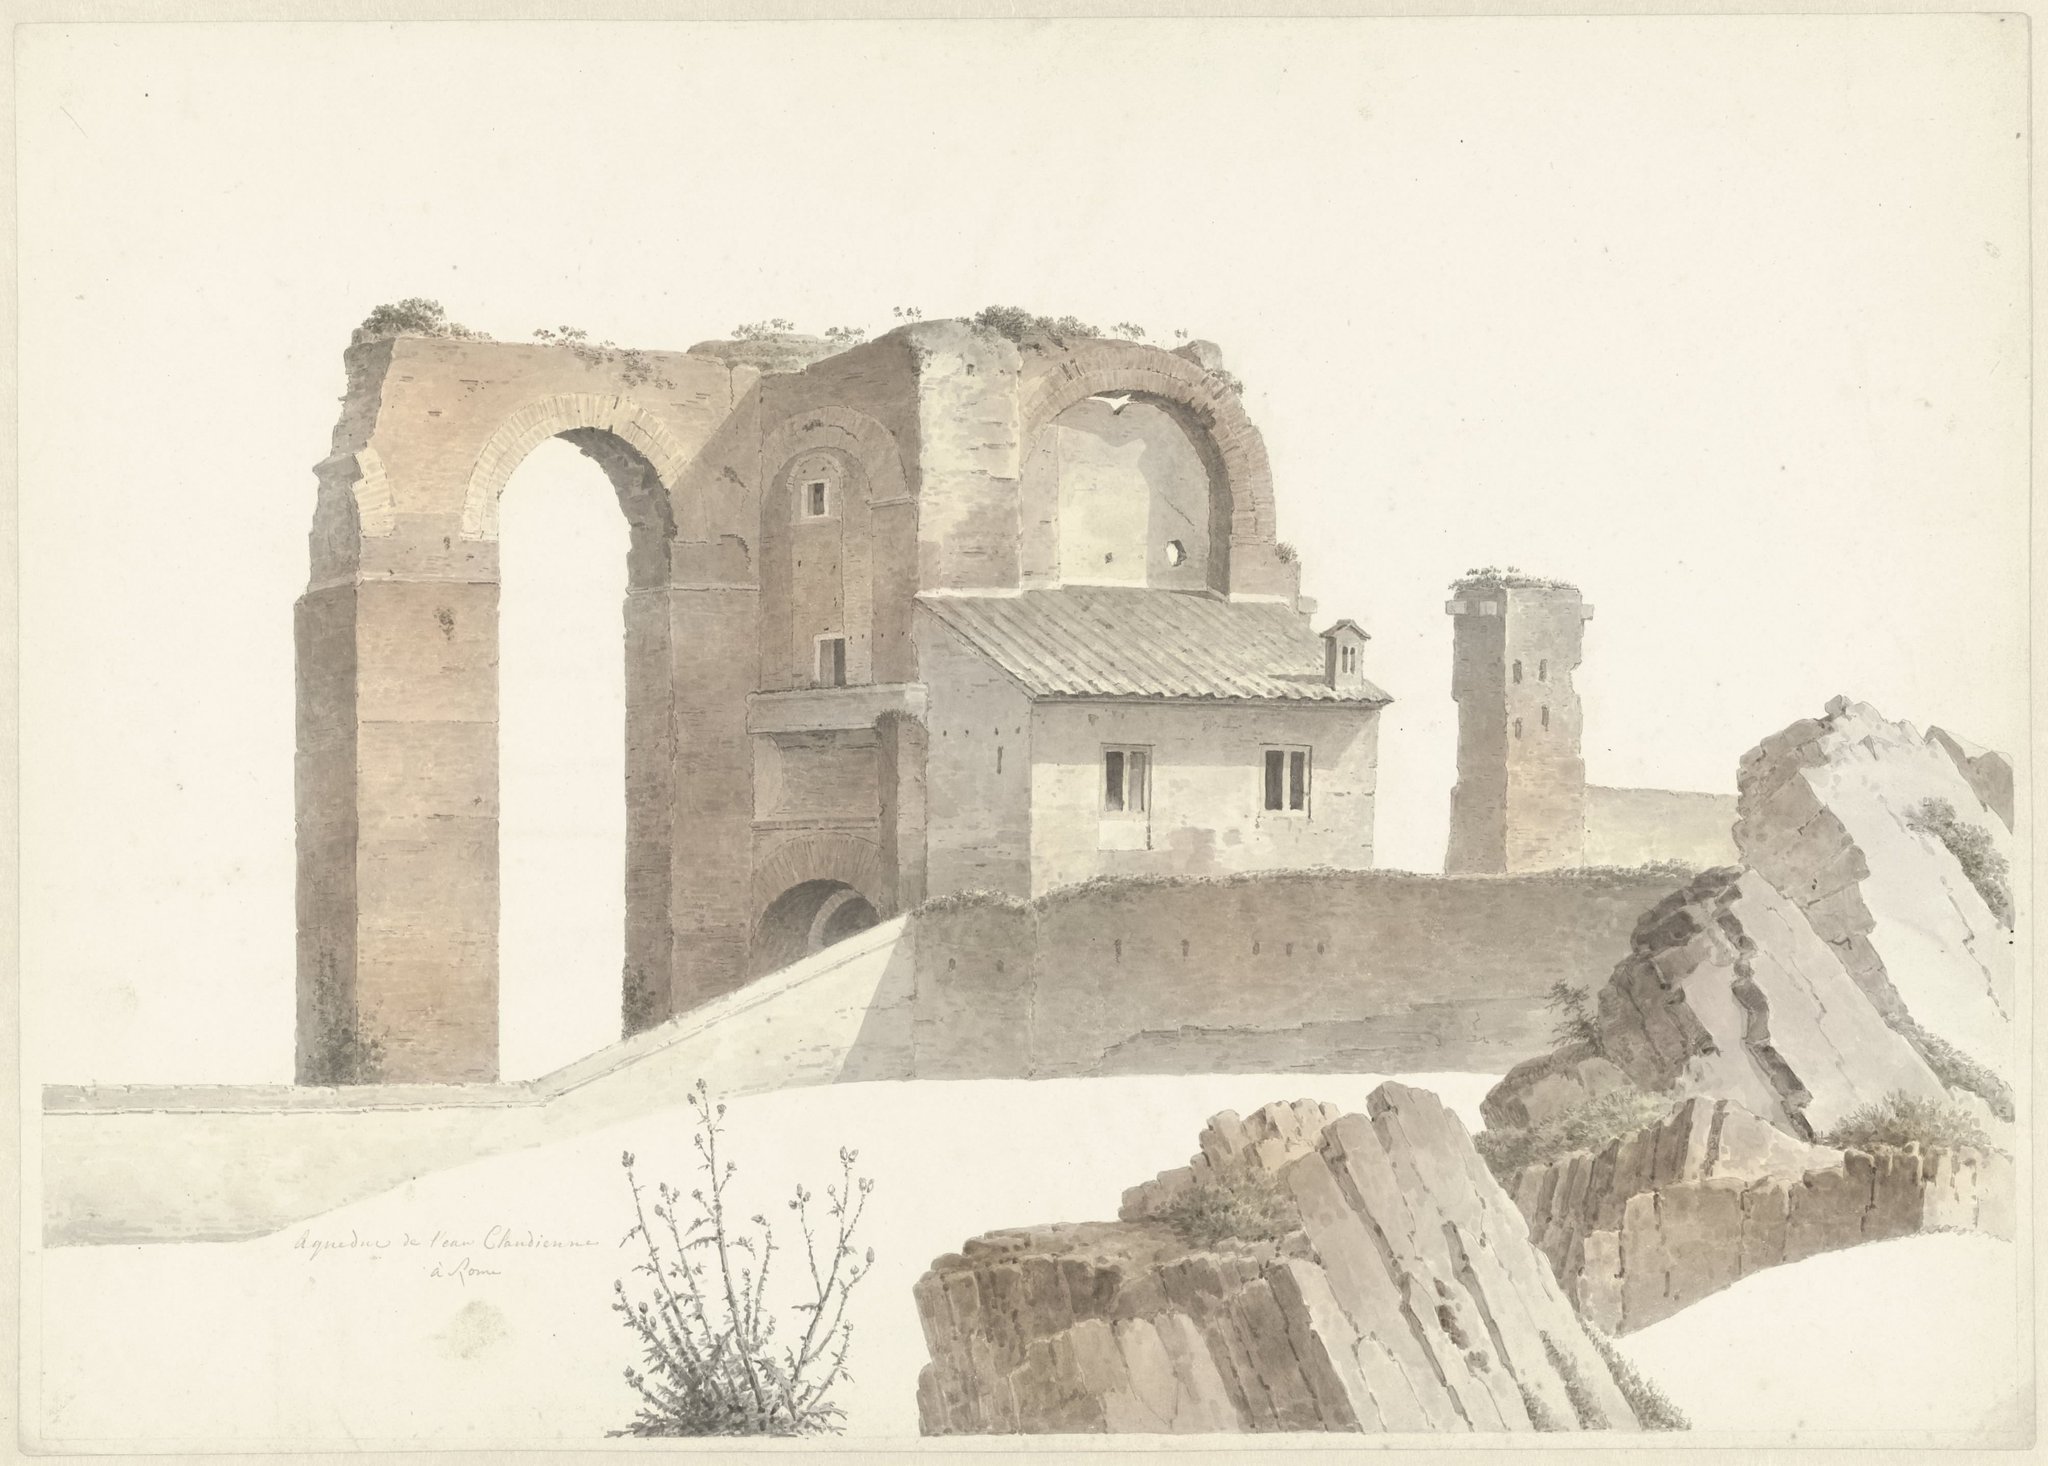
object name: drawing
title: The Aqua Claudia in Rome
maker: josephus augustus knip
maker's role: draughtsman, painter, print maker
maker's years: 1777-1847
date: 1809-1812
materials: graphite, paper, watercolor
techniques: brush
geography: italy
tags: ruin of a building ~ architecture, landscape with ruins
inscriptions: inscription: ‘Aqueduc de l' eau Claudiane / à Rome’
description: Scattered throughout the ancient city centre of Rome are the remains of the Aqua Claudia. Constructed in the 1st century AD, this aqueduct provided drinking water to large parts of the city. Knip drew the spot where the aqueduct is built over an old city gate not far from the basilica of Santi Giovanni e Paolo.